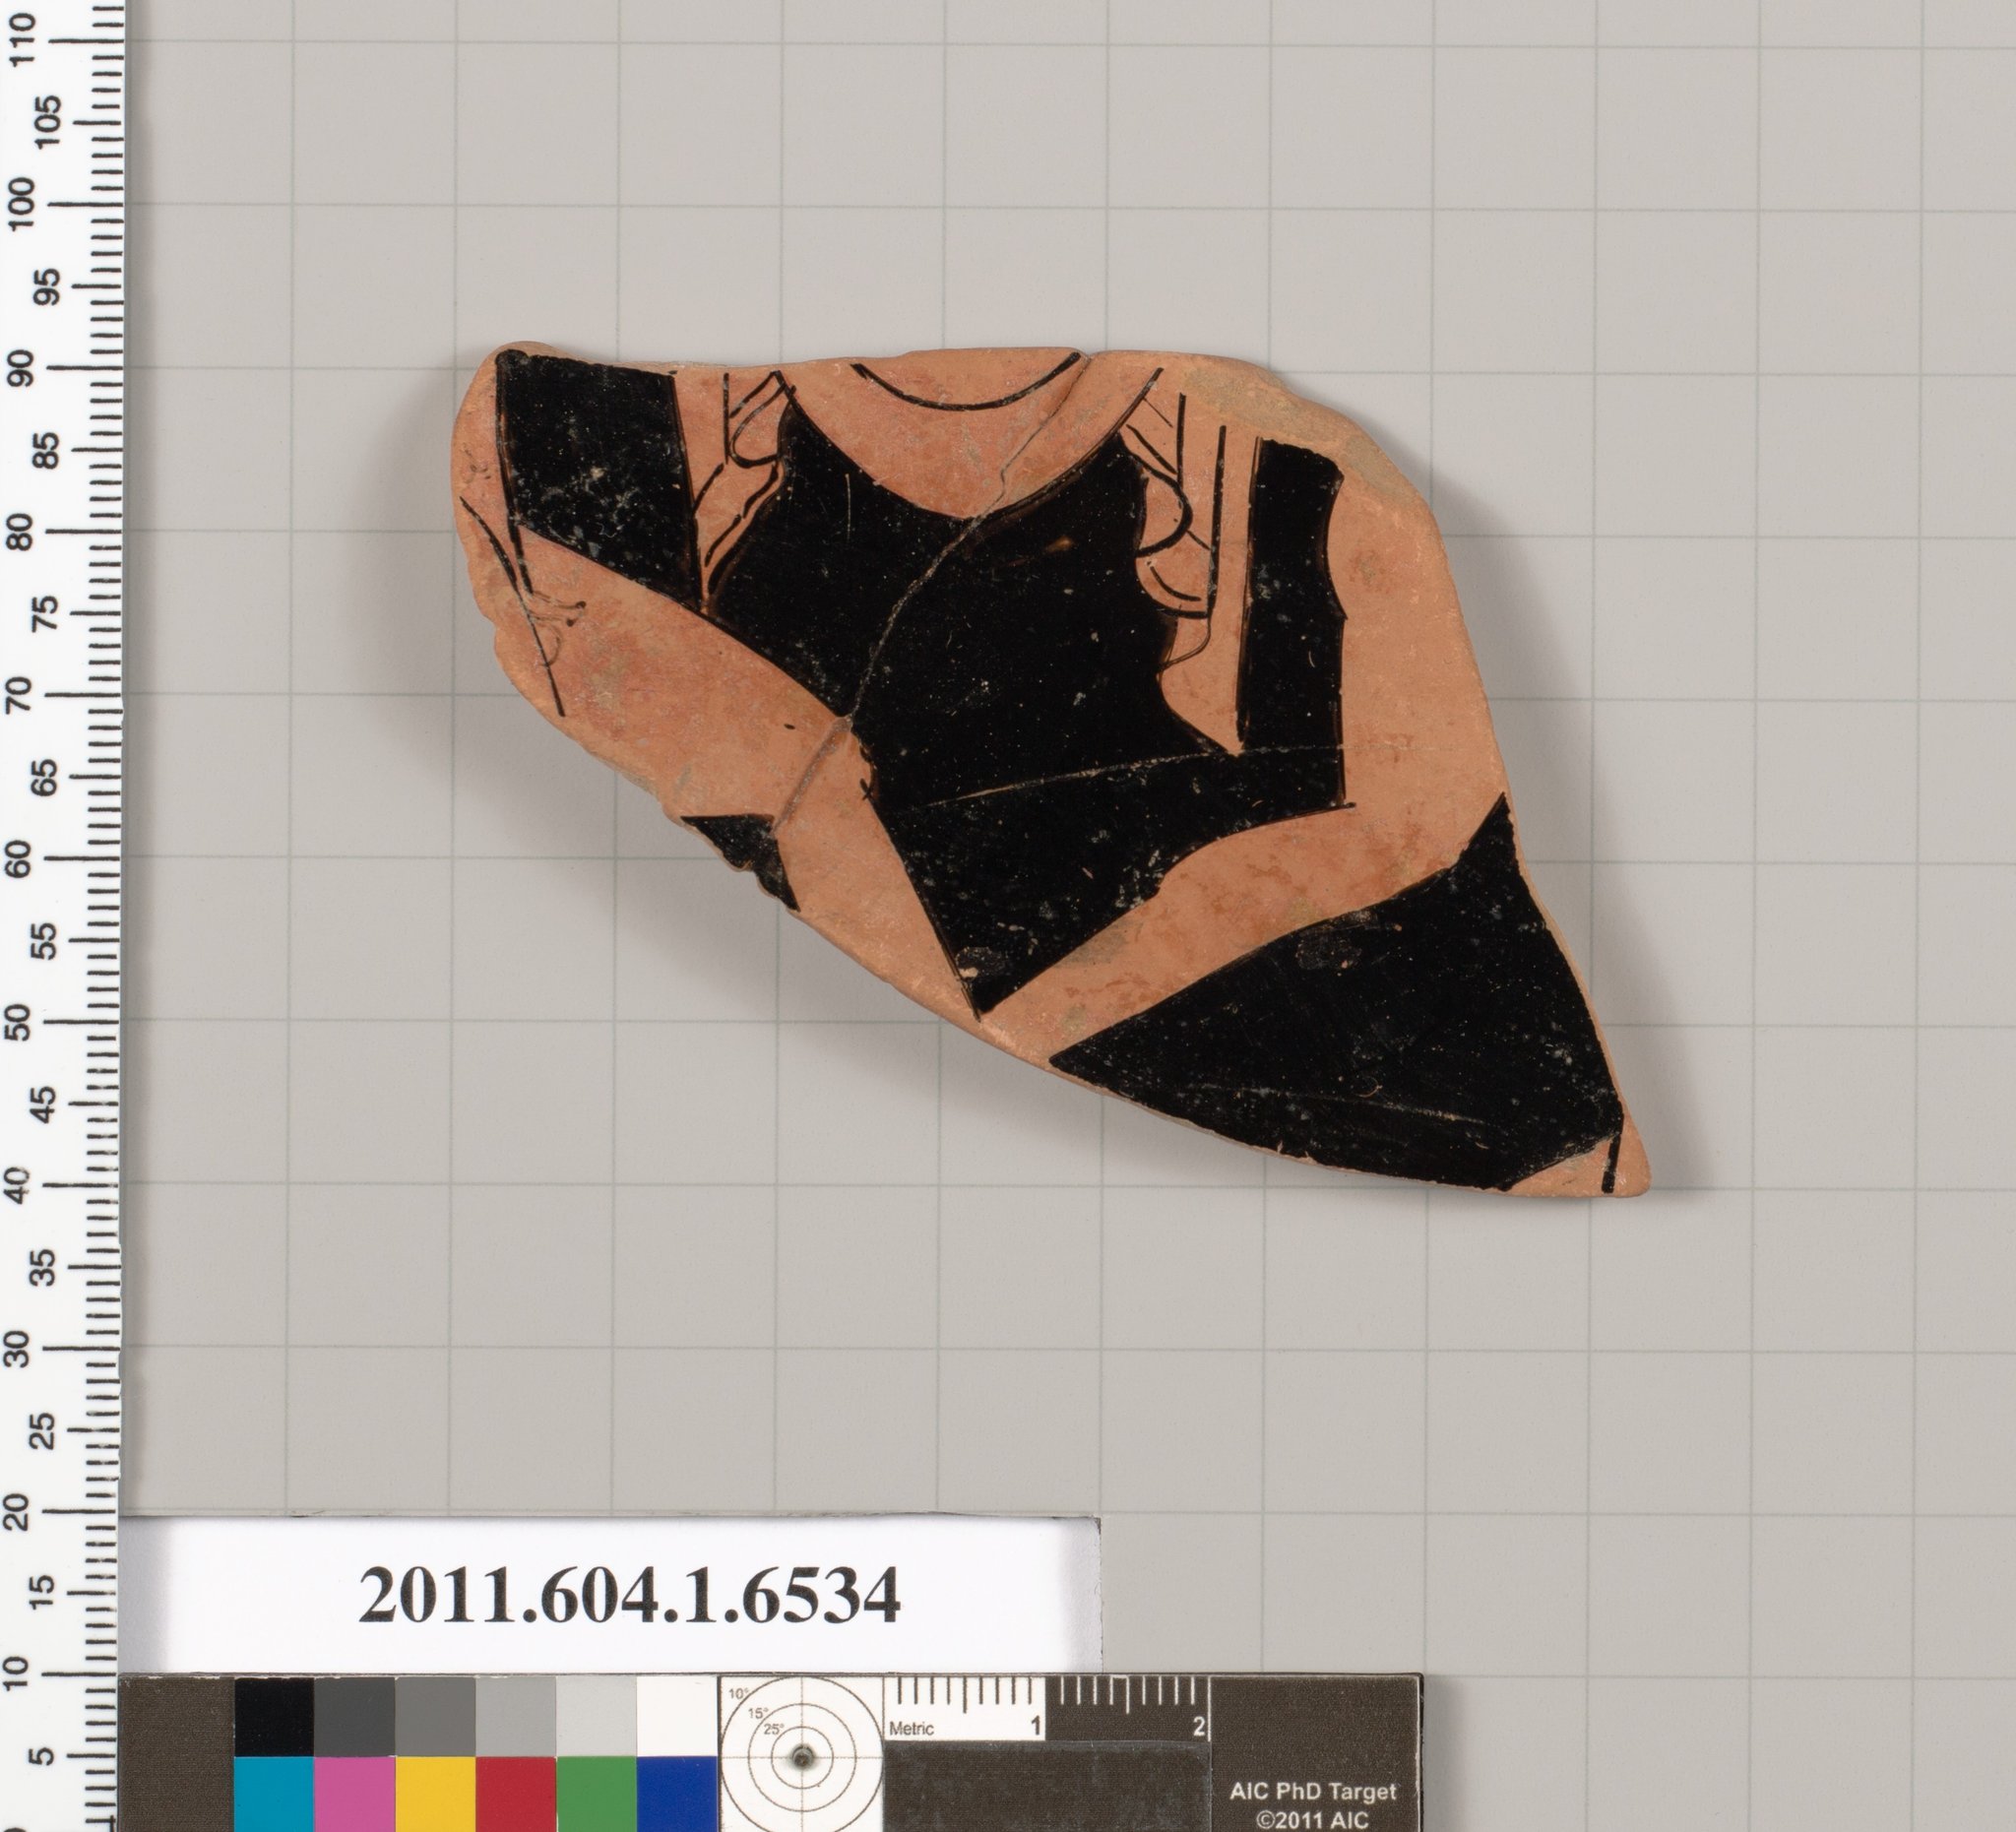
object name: kylix fragment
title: Terracotta fragment of a kylix (drinking cup)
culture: greek, attic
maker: colmar painter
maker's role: artist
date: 490-480 BCE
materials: terracotta